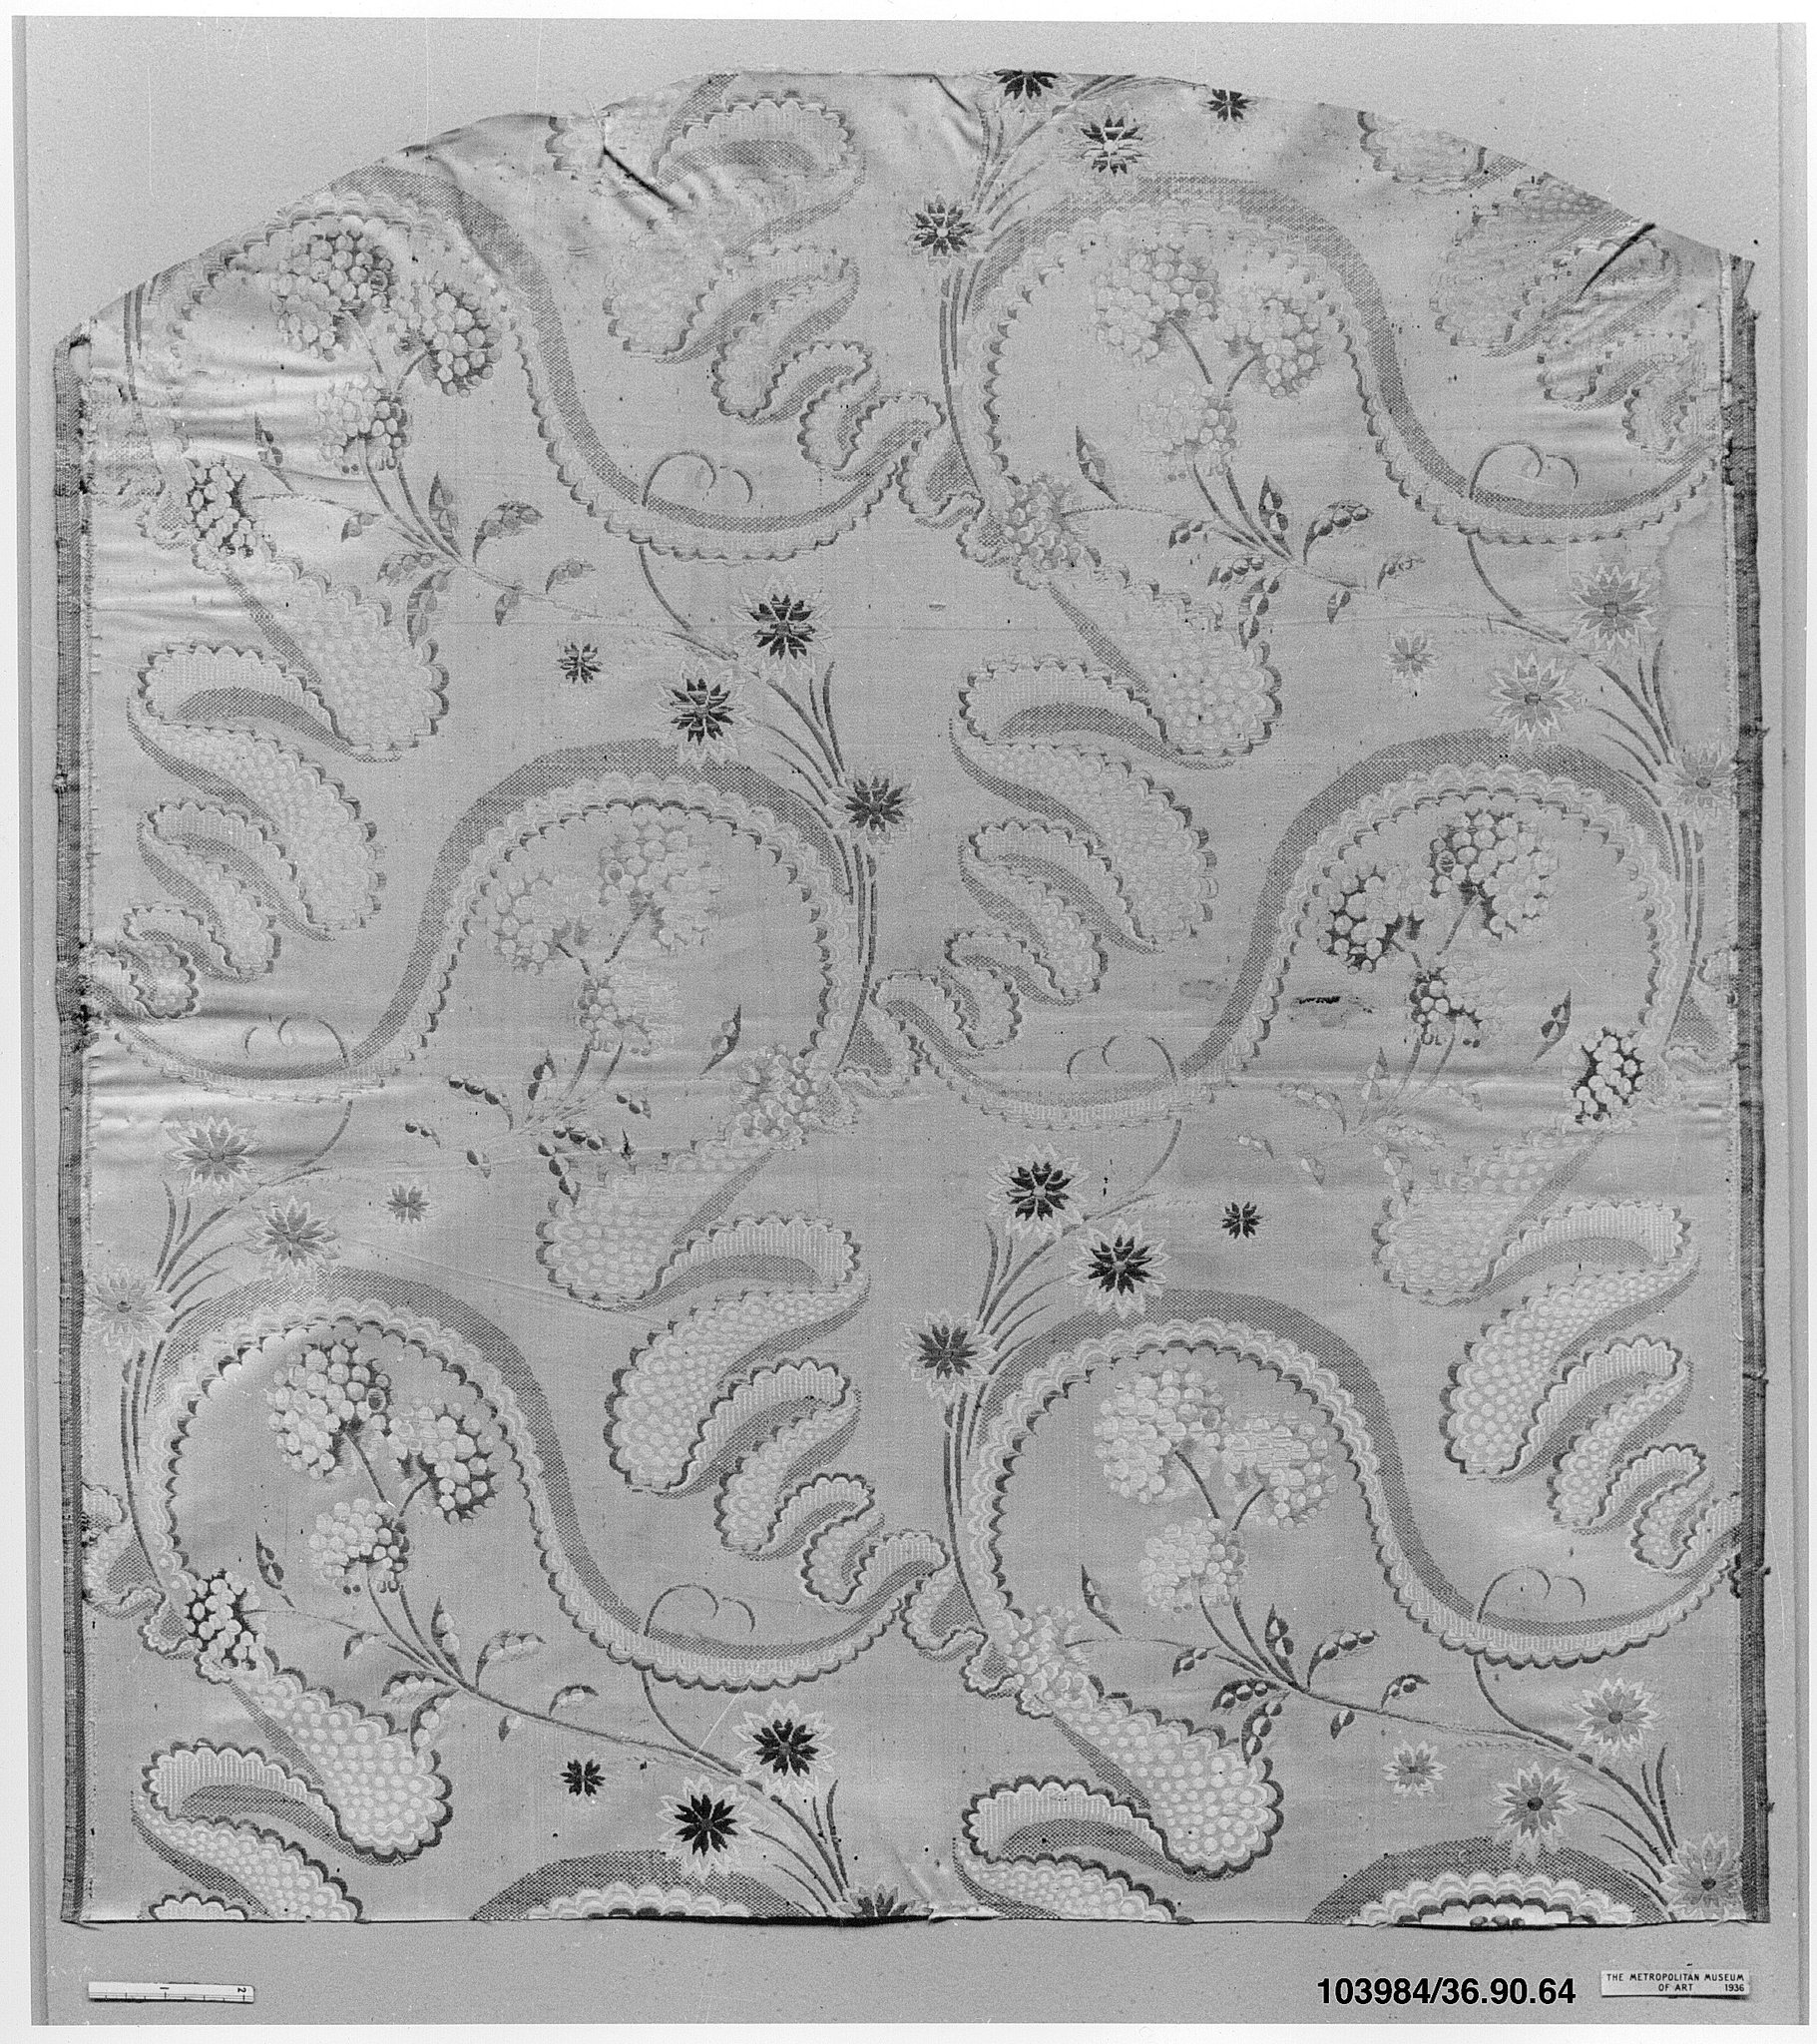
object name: piece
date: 1750-1760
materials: silk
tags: flowers